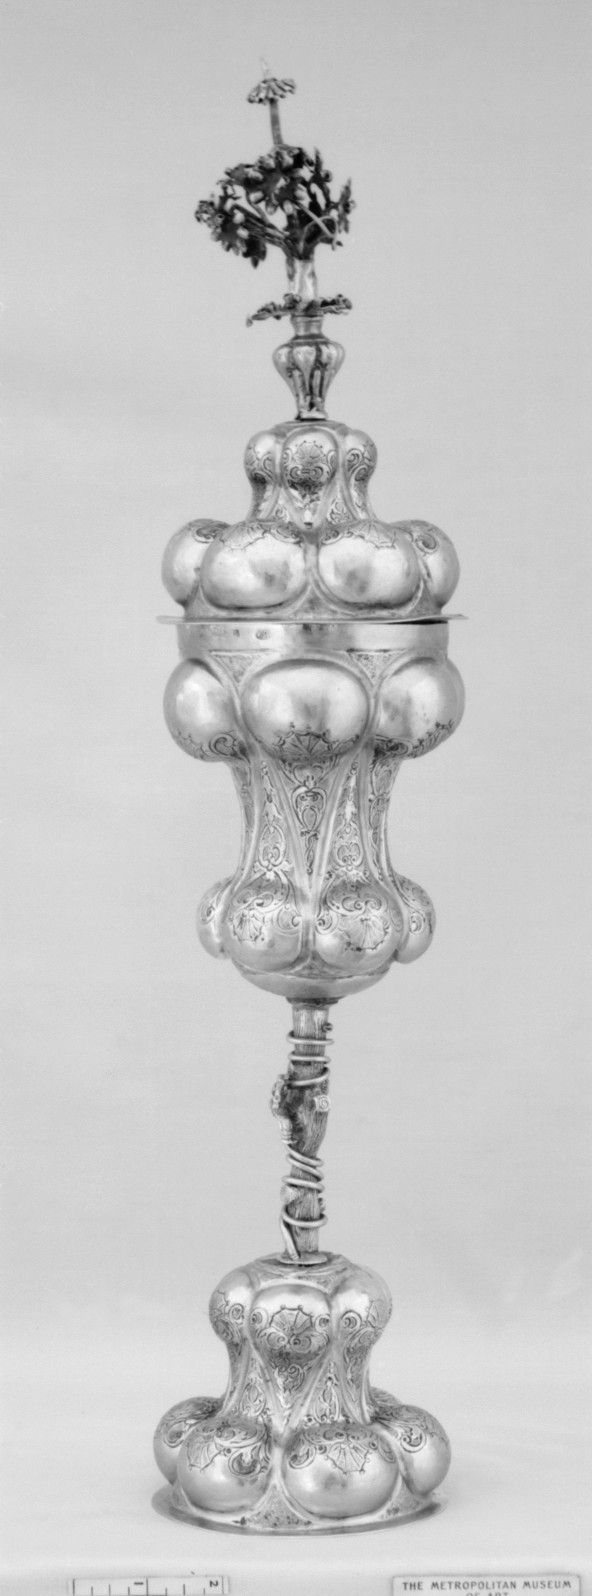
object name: hanap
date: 1701-1800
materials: gilt, silver